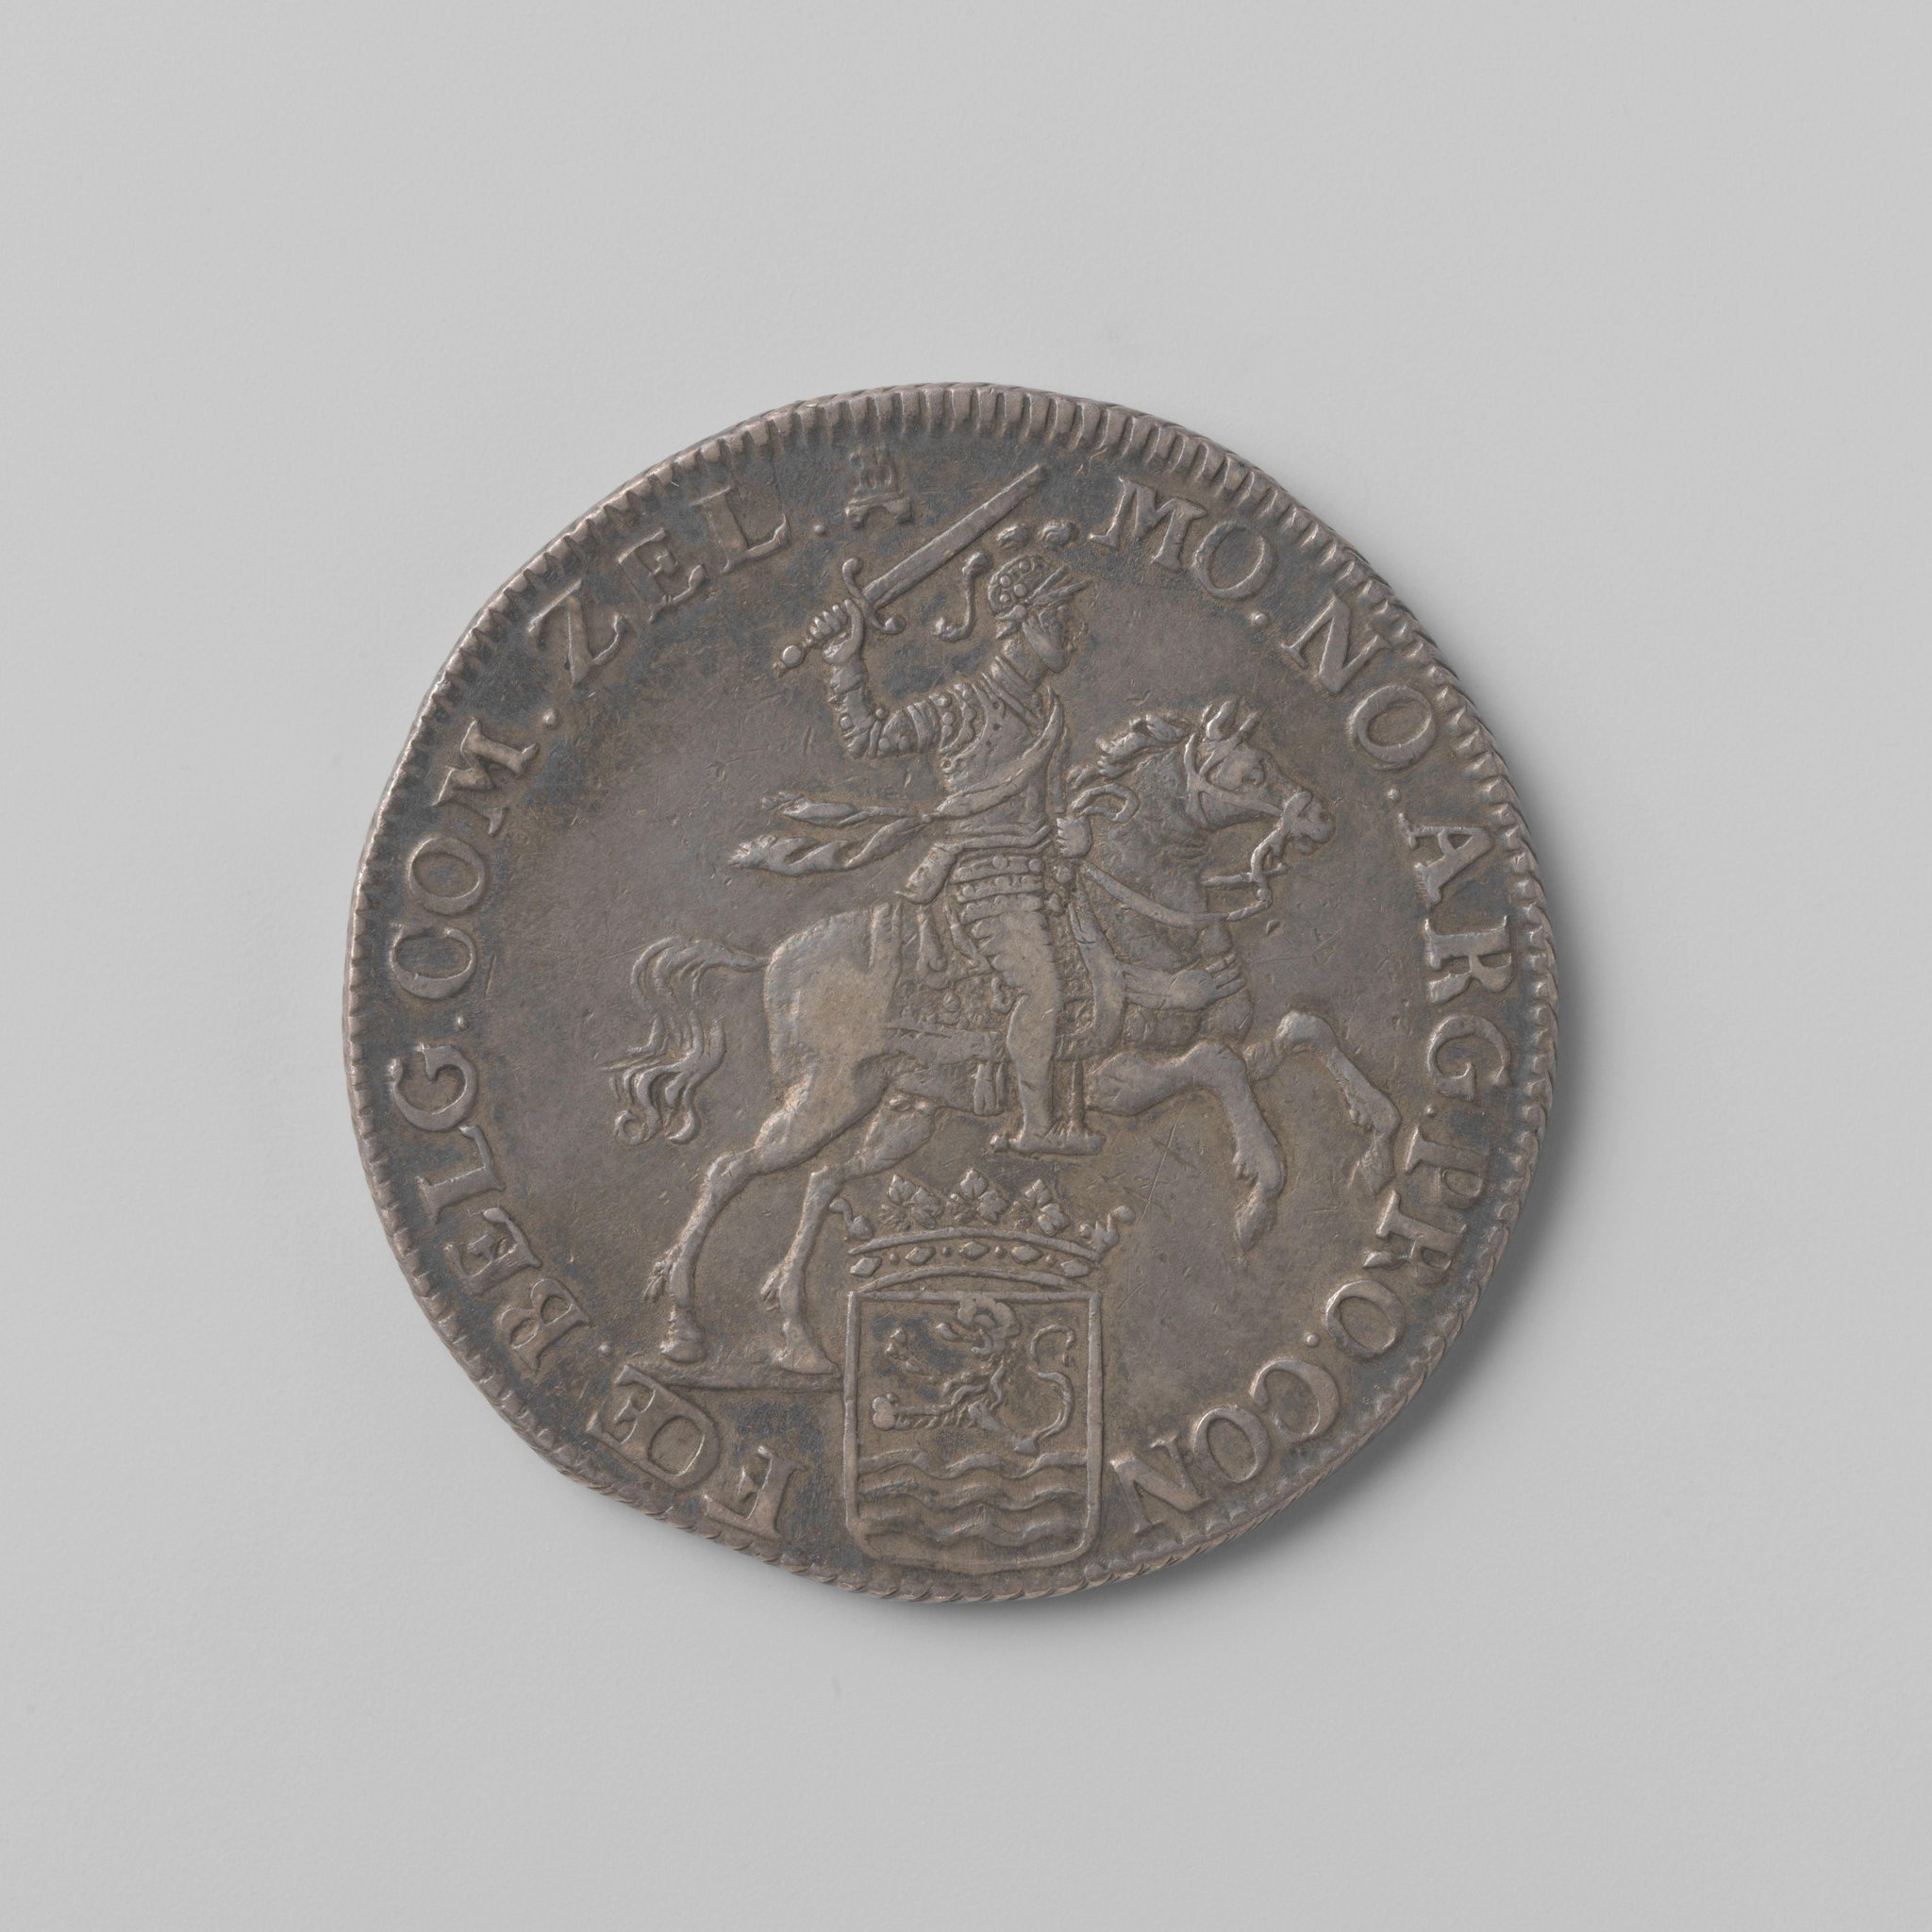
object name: coin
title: Zeeland, zilveren rijder, 1754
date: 1754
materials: silver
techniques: striking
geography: middelburg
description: Zilveren munt. Voorzijde: geharnaste ridder te paard naar rechts met zwaard in rechterhand. Daaronder gekroond wapenschild van Zeeland voor zich. Keerzijde: door twee leeuwen gwehouden gekroond generaliteitswapenschild, waaronder cartouche, waarin jaartal. Kabelrand.